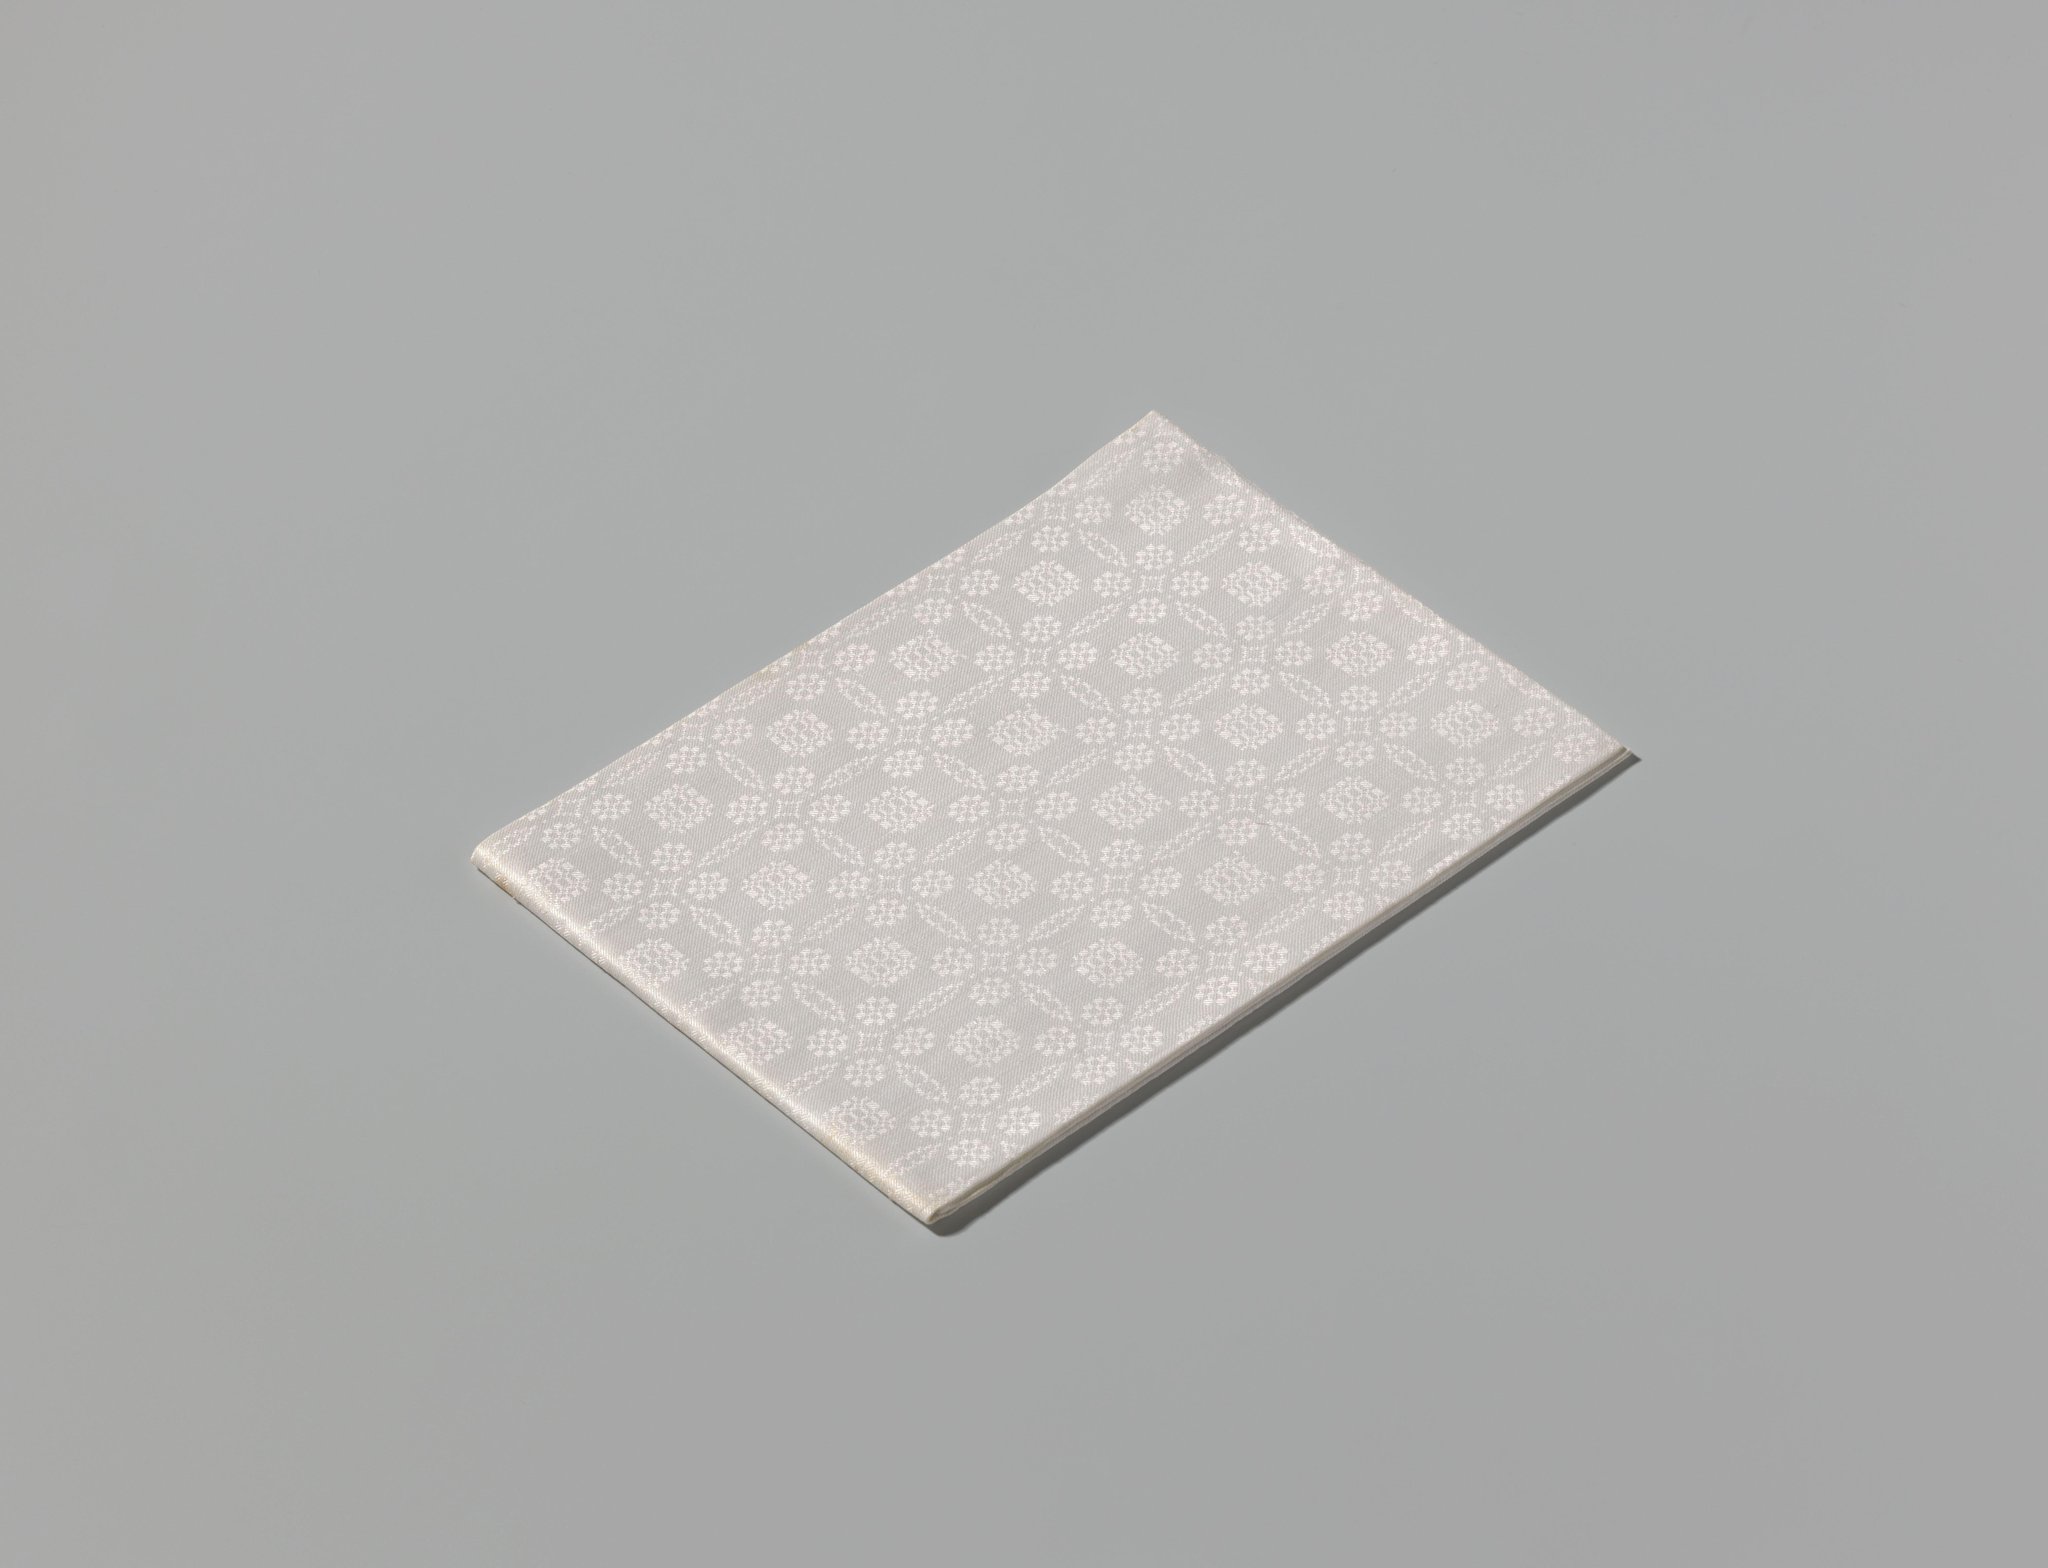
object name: towel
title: Handdoek van wit linnen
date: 1600-1699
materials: linen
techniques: twill, peeled fabric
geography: netherlands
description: Wit linnen handdoek met een pellen patroon in keper, merk kroon RR (?).